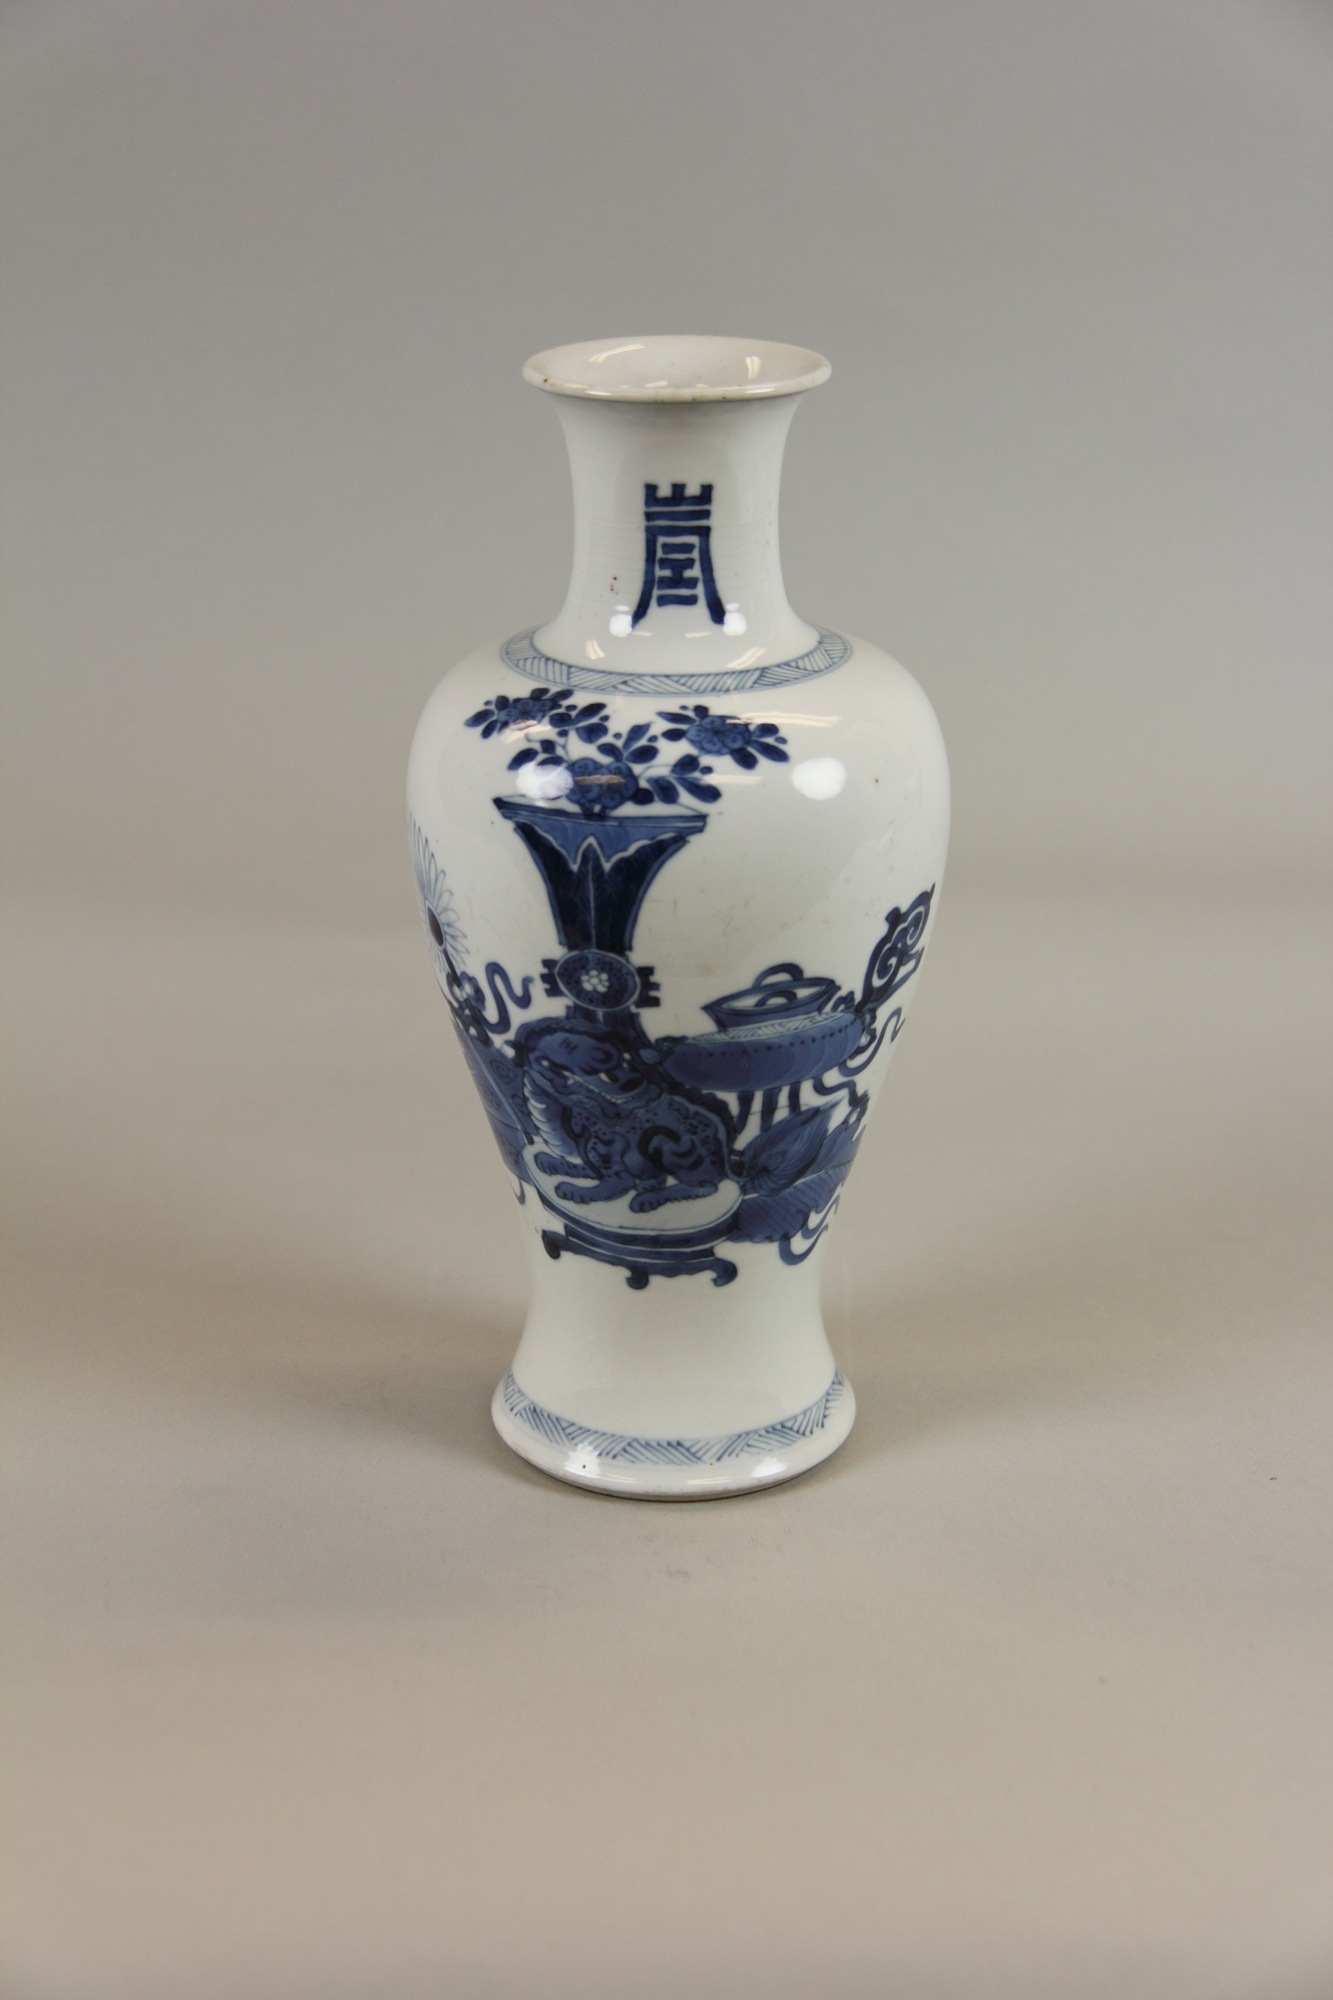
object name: vase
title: Vase with a display of antiques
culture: chinese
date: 1667-1733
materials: cobalt, porcelain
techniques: painting, underglaze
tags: animals,flowers